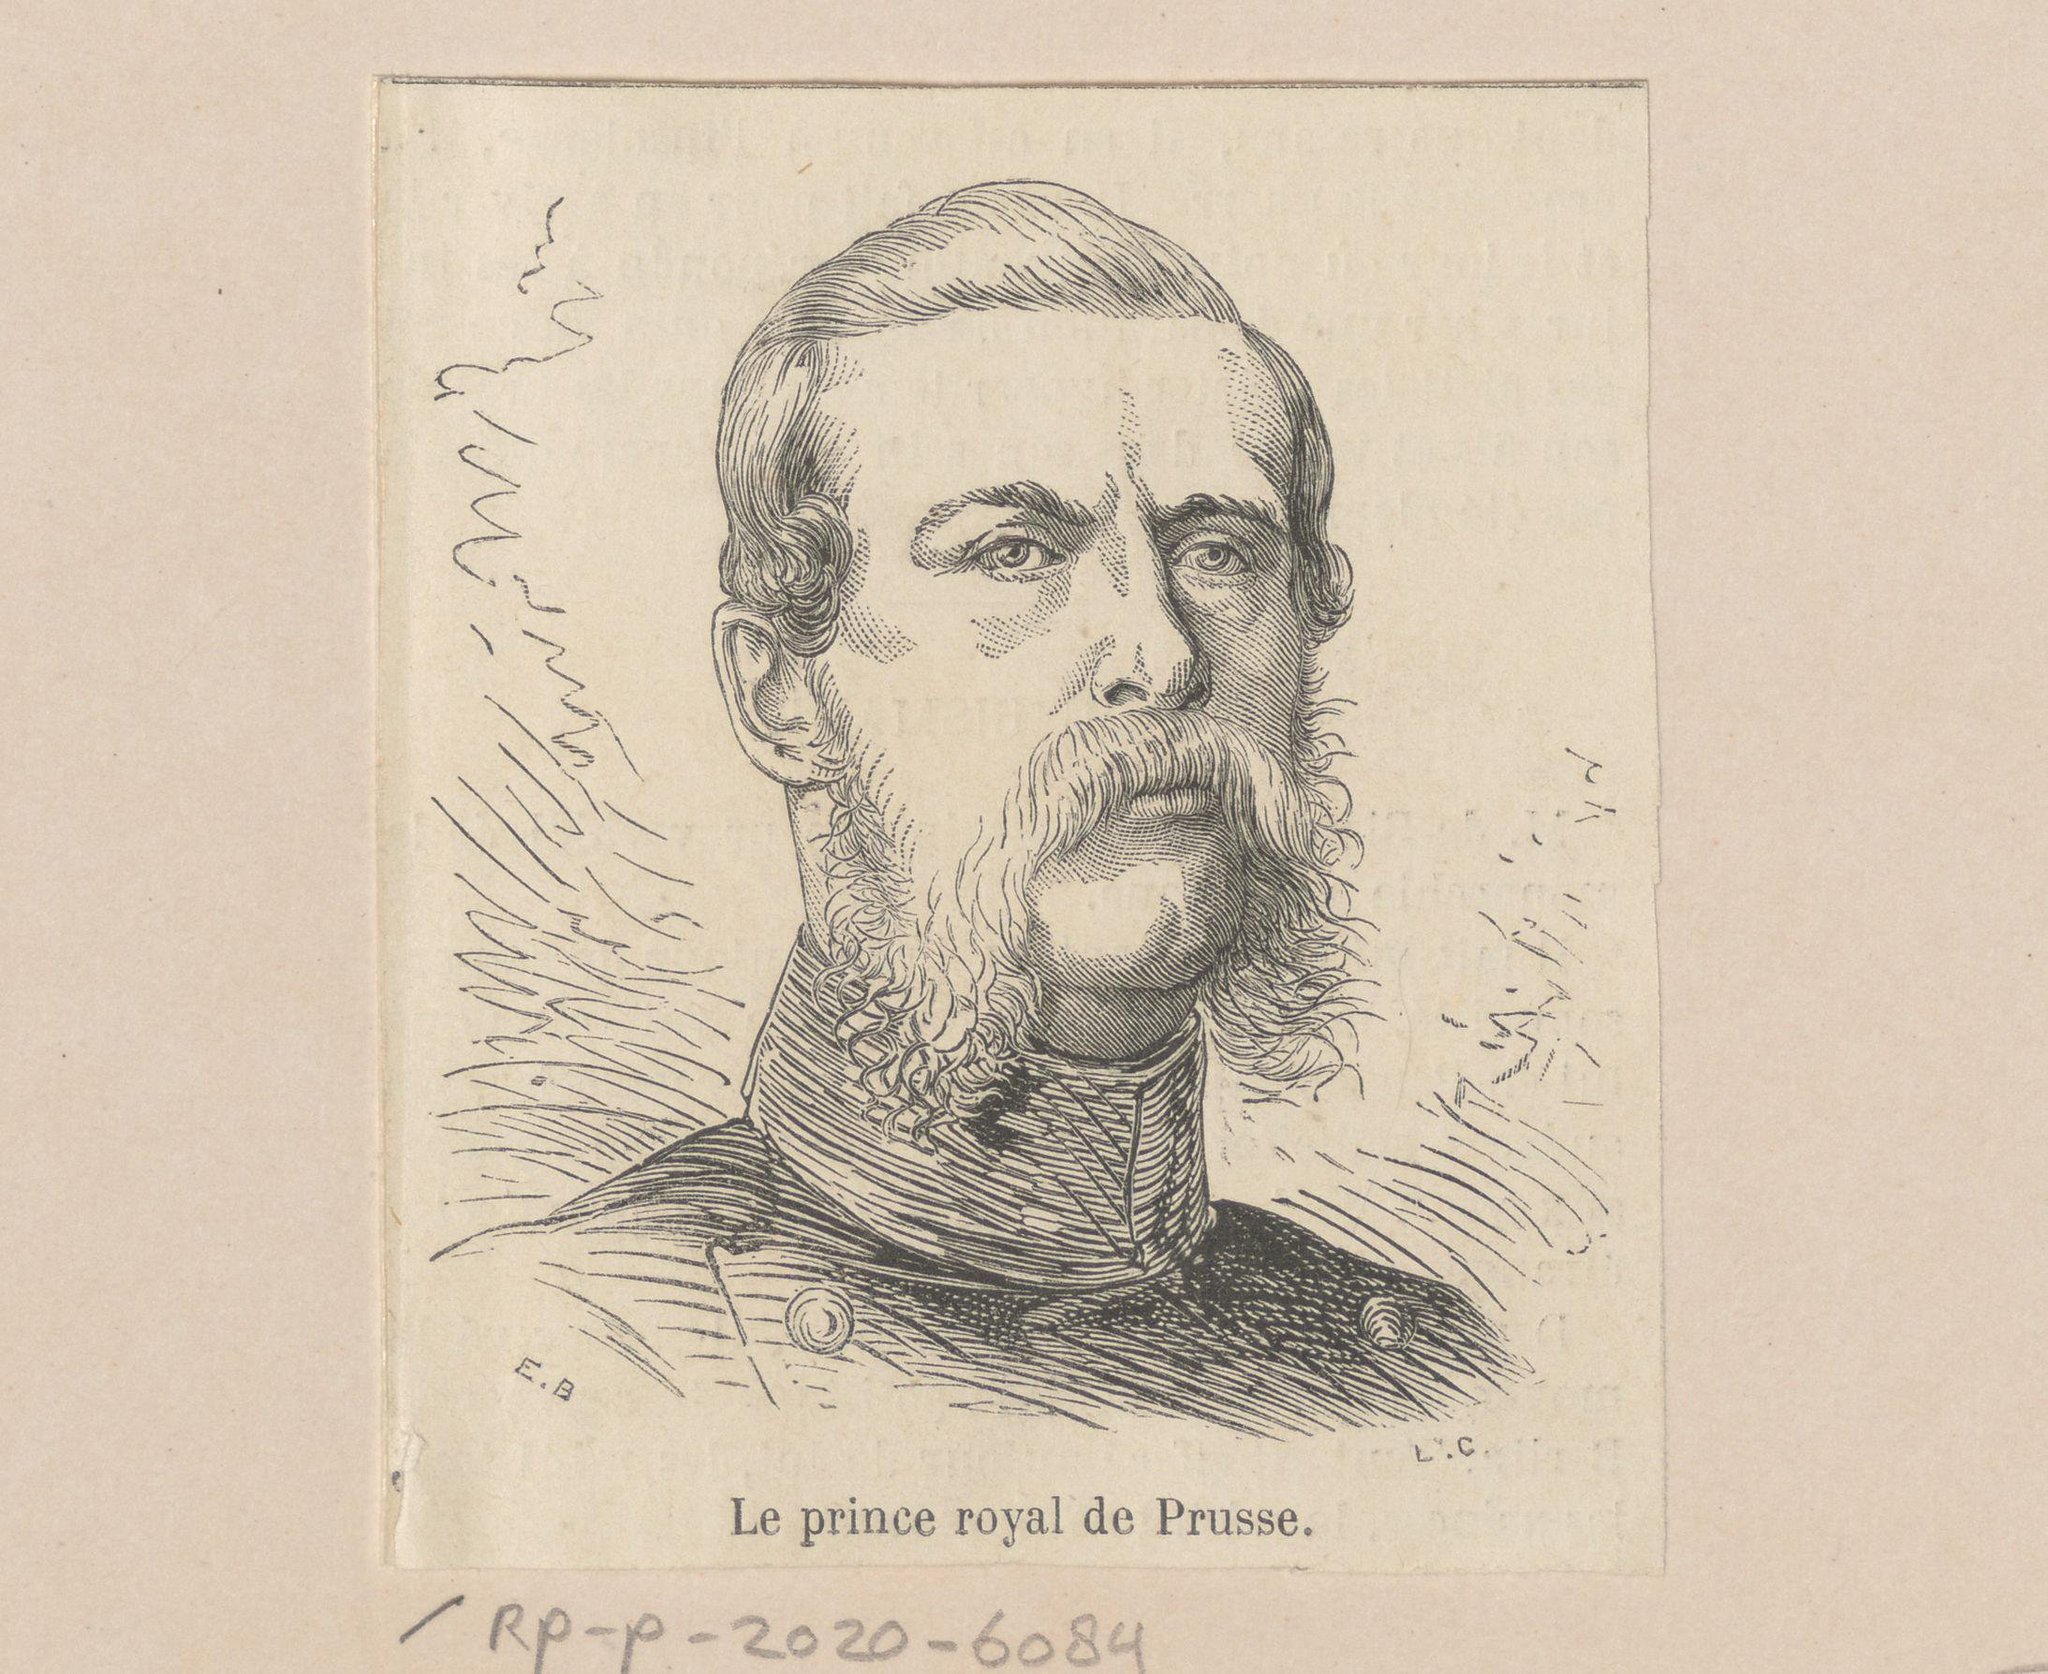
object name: print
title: Portret van Frederik III als kroonprins van Pruisen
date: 1870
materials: paper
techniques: letterpress printing, engraving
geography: paris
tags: historical persons, crown prince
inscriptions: monogram: ‘E.B’, monogram: ‘L.C’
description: Prent uit: Le Monde Illustré 14 (1870), nr. 696, 13 augustus 1870.